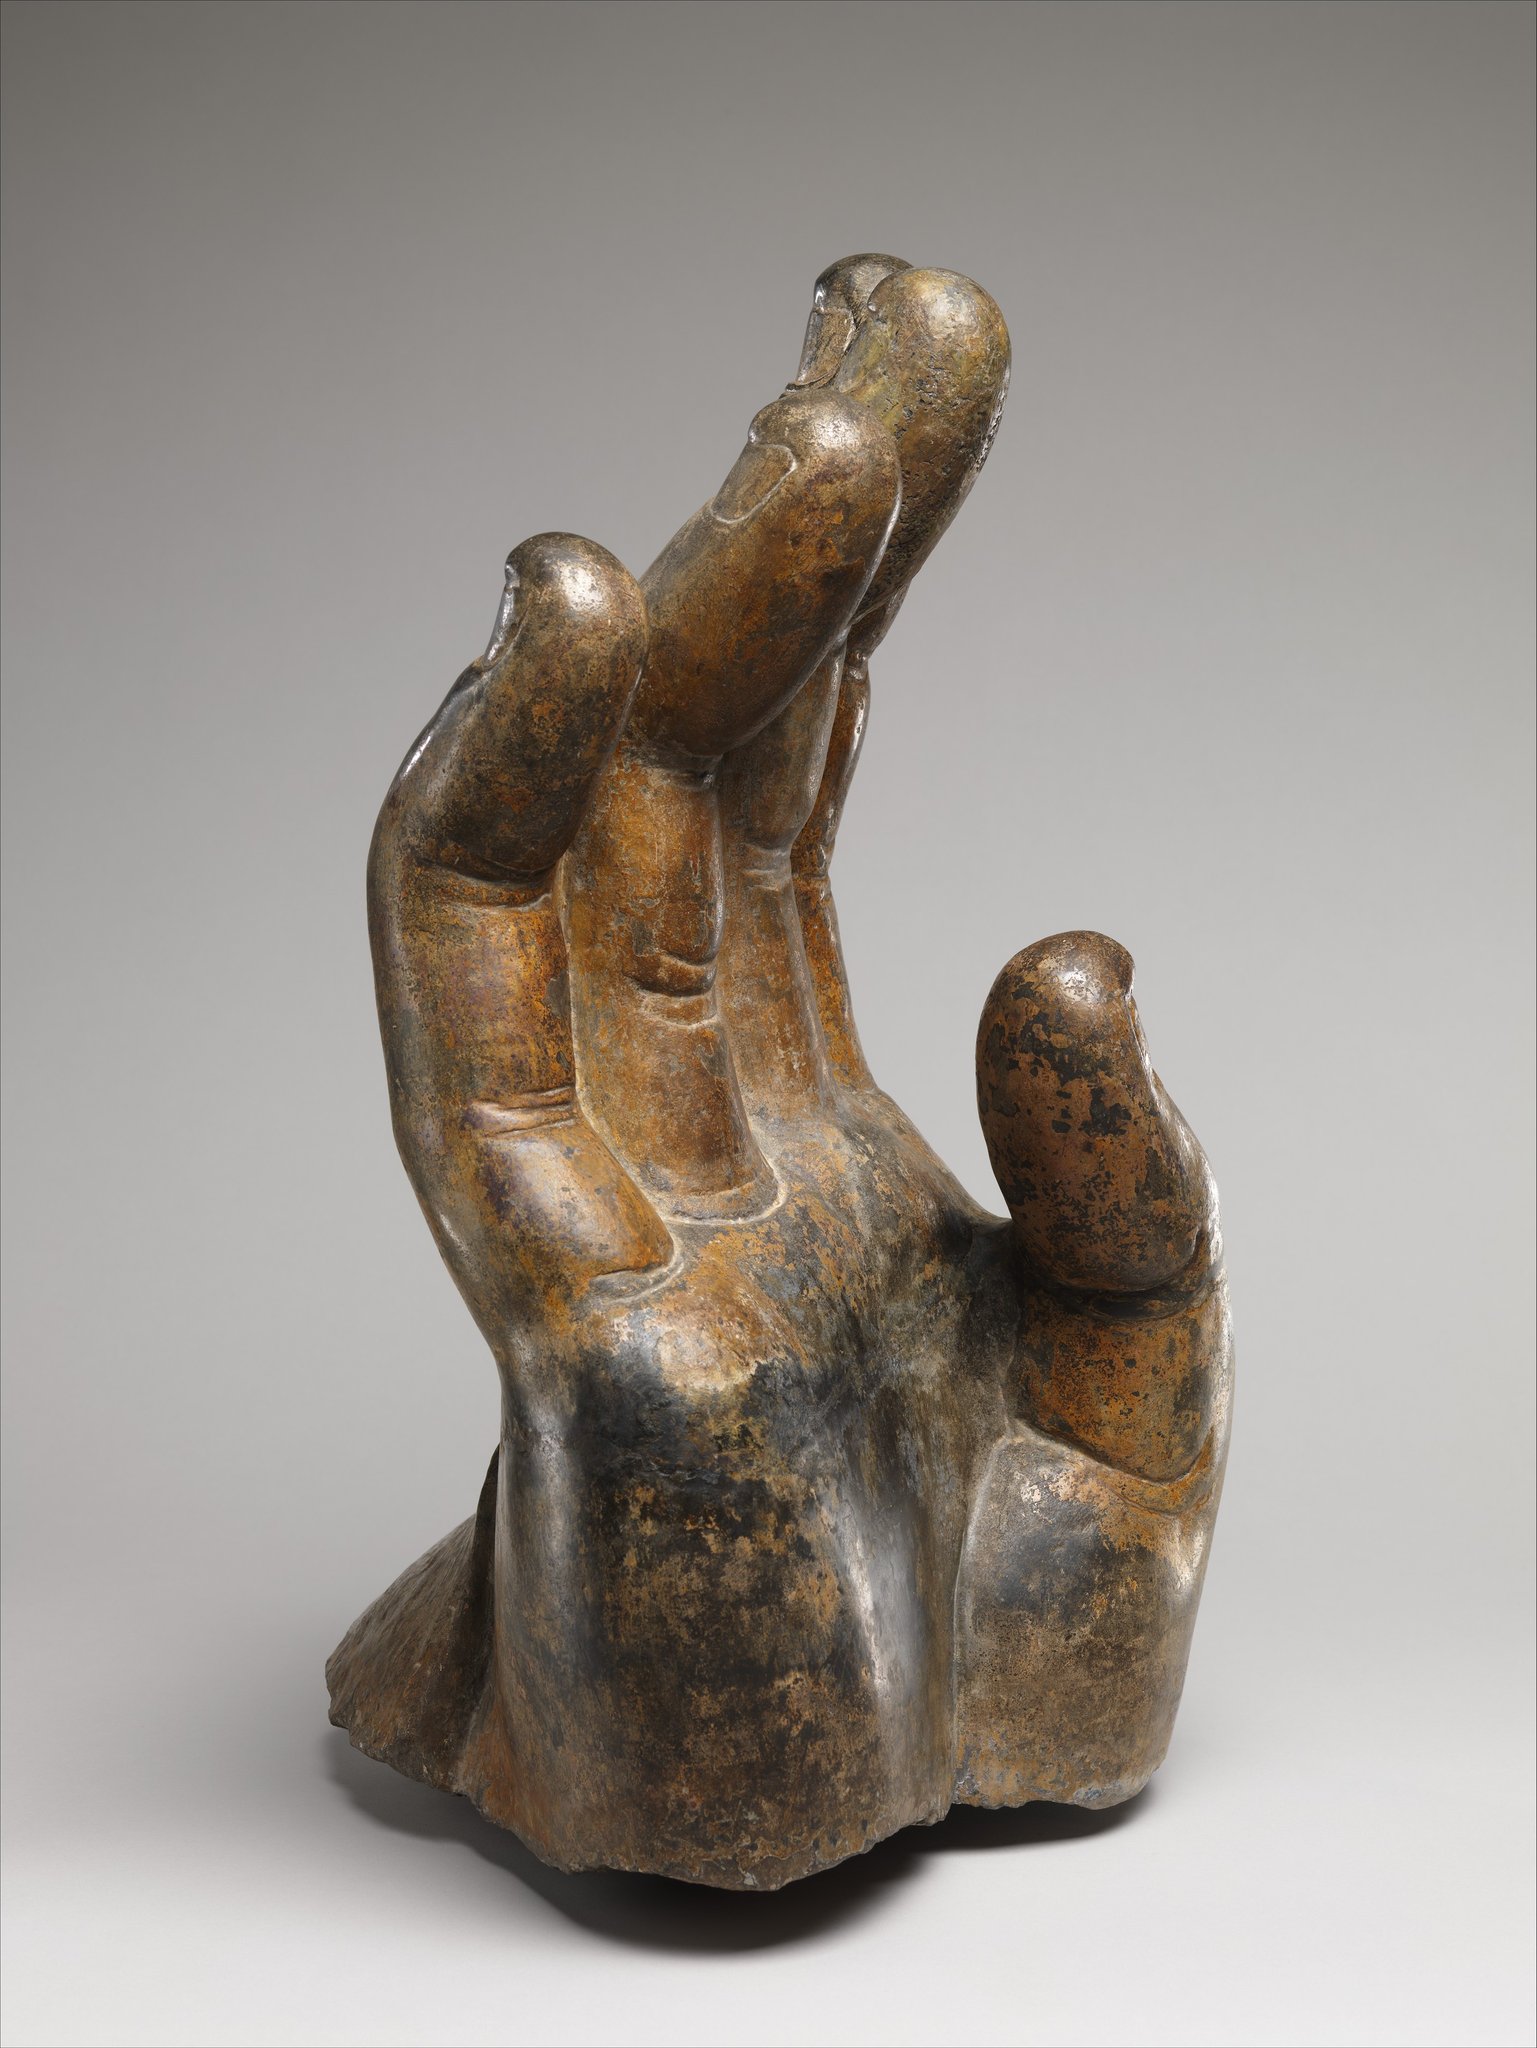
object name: sculpture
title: Right hand of Buddha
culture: chinese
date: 550-560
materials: limestone, pigment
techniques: gilding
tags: buddha